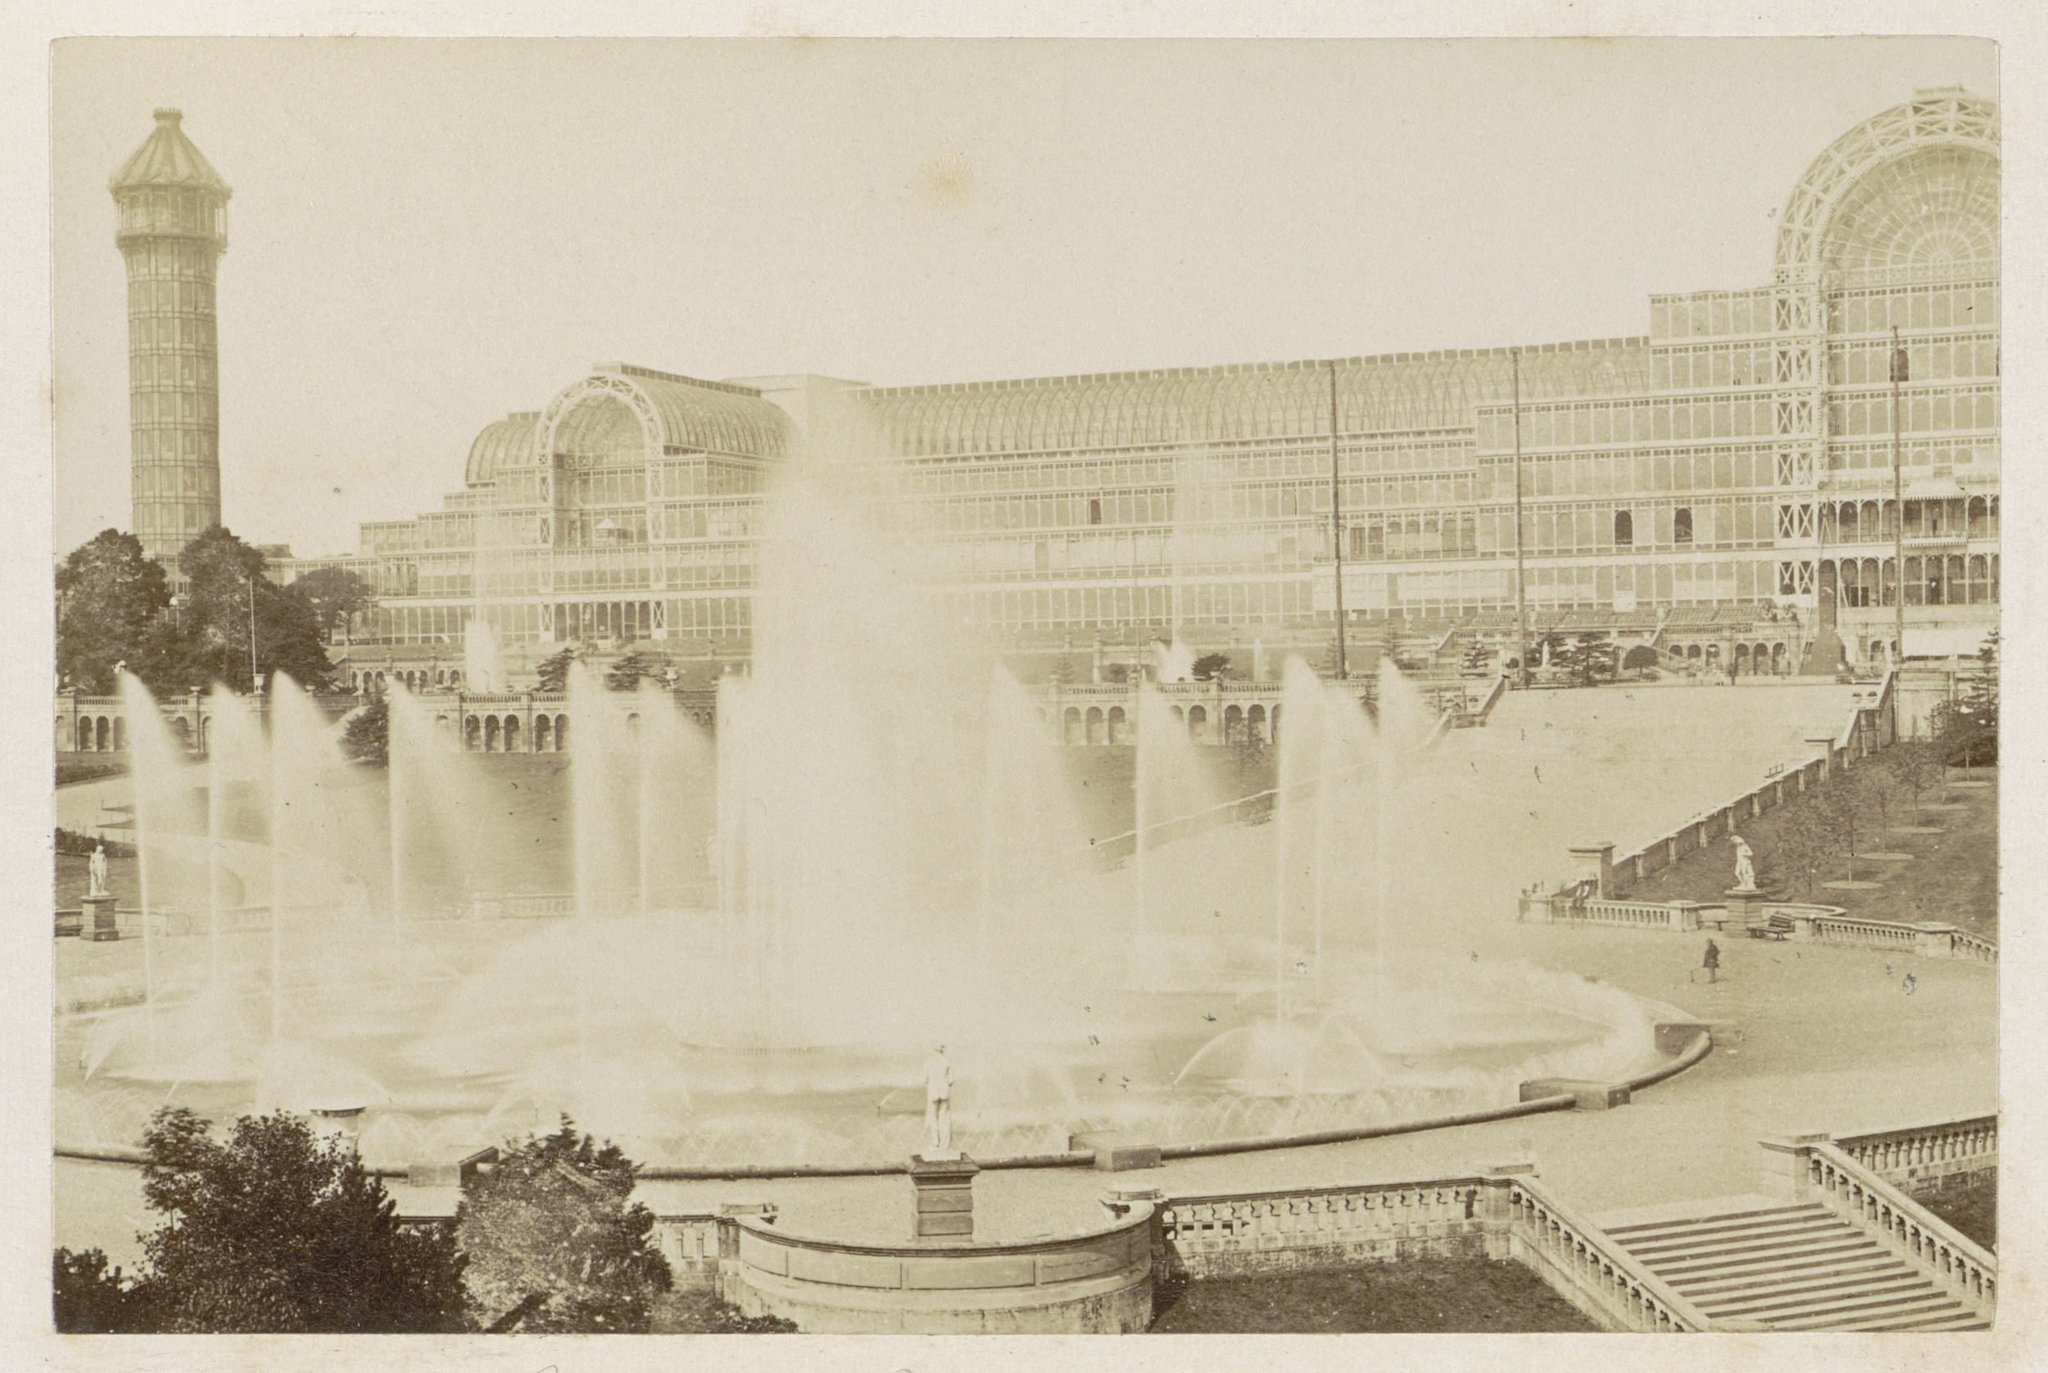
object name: photograph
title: Chrystal Palace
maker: Anonymous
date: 1878-1890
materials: photographic support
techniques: albumen print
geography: london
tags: water tower, garden fountain, exterior ~ representation of a building, london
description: Onderdeel van Reisalbum Europese steden, vermoedelijk Zweeds.